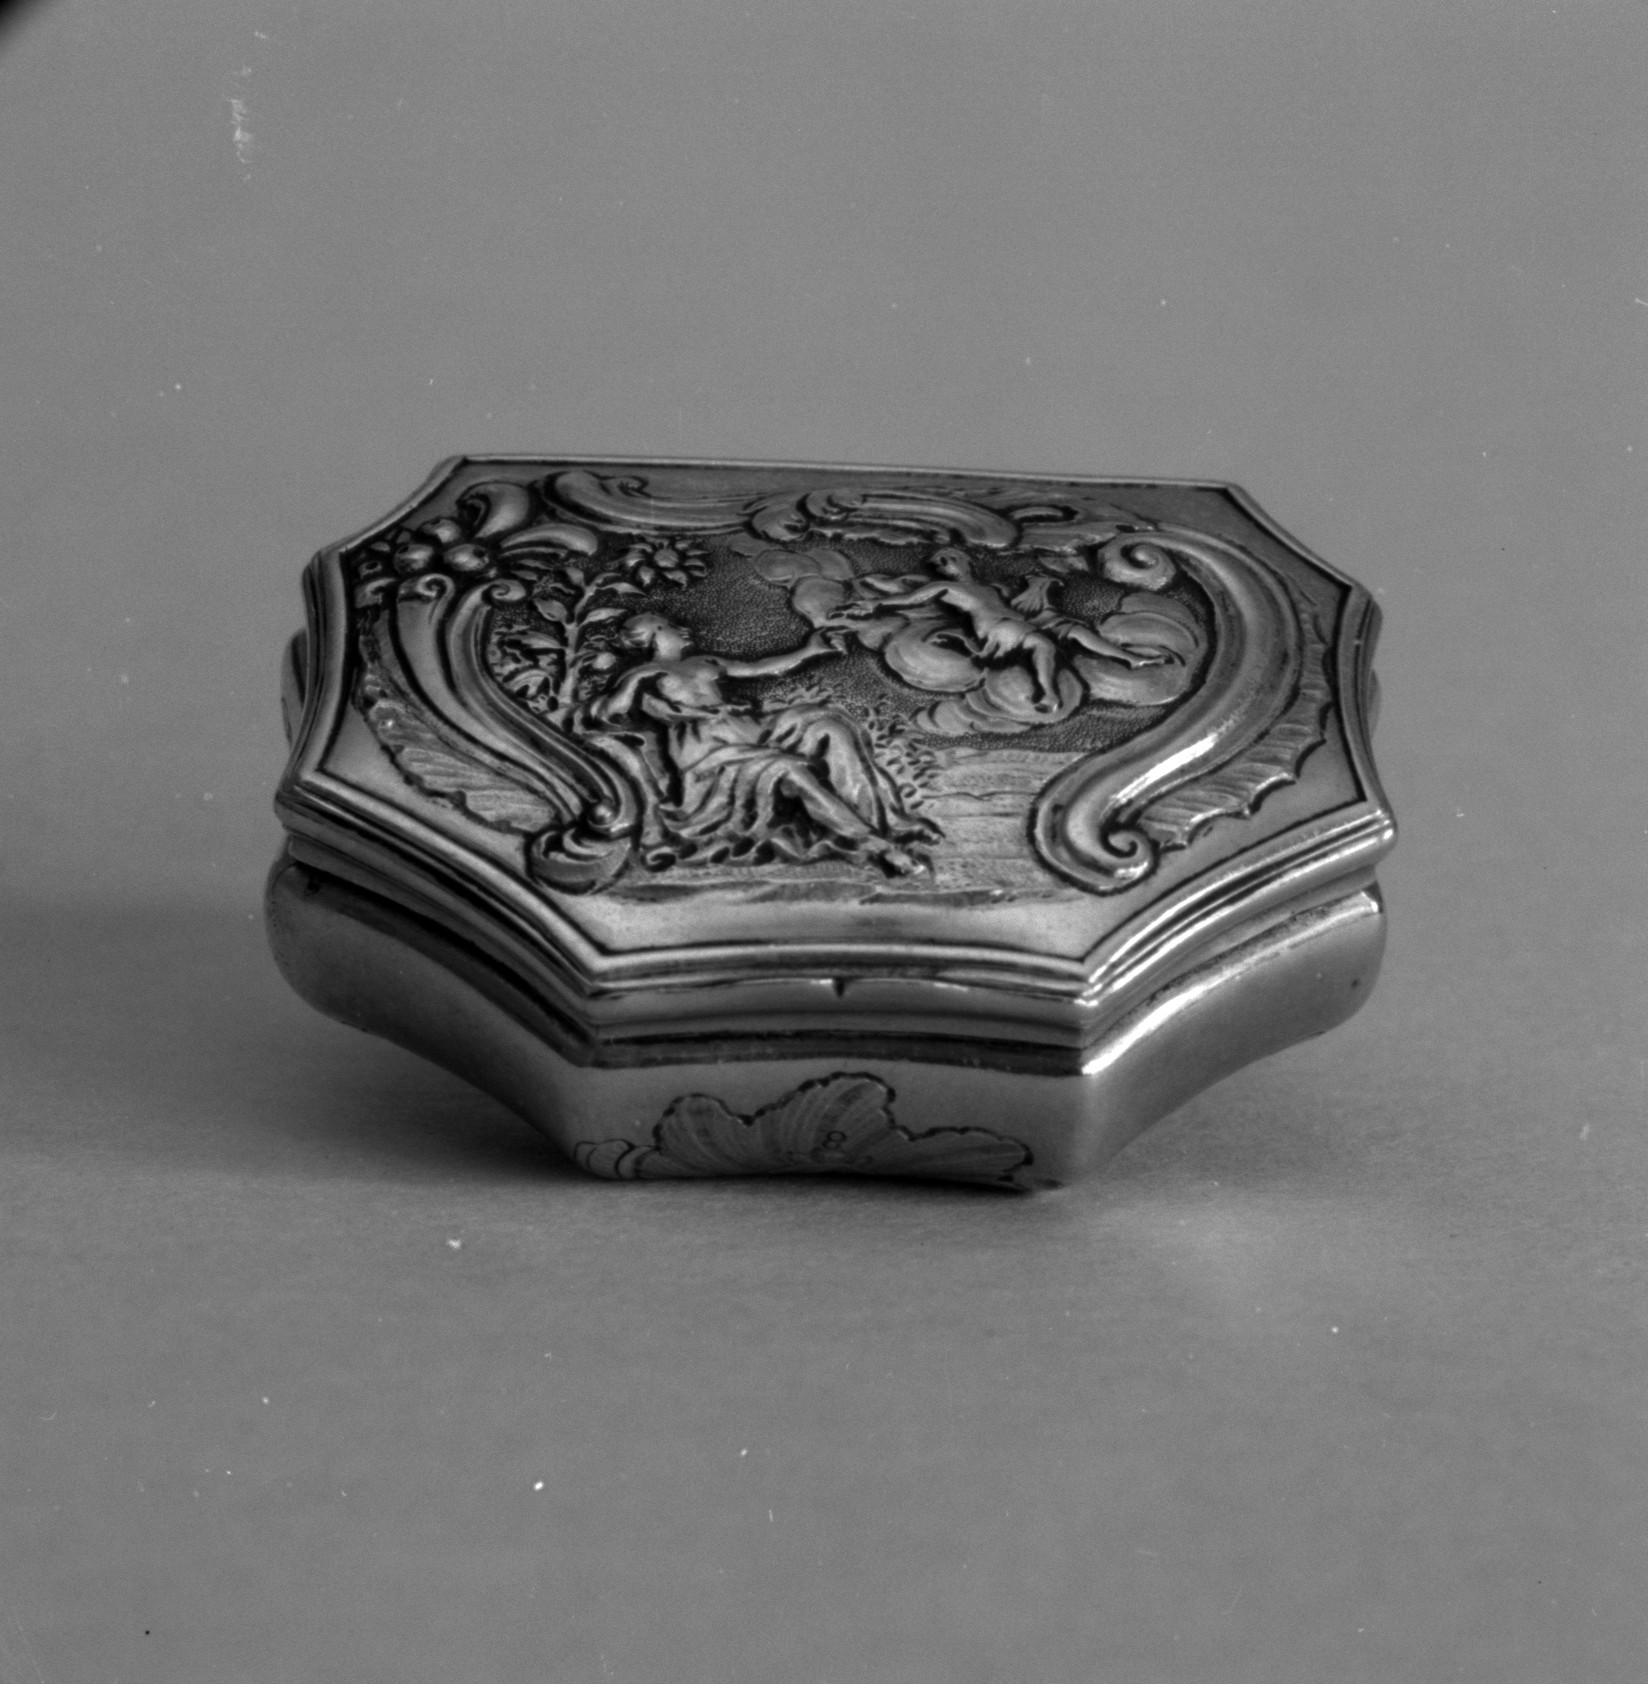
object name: snuffbox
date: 1730-1740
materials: gold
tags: men,female nudes,trees